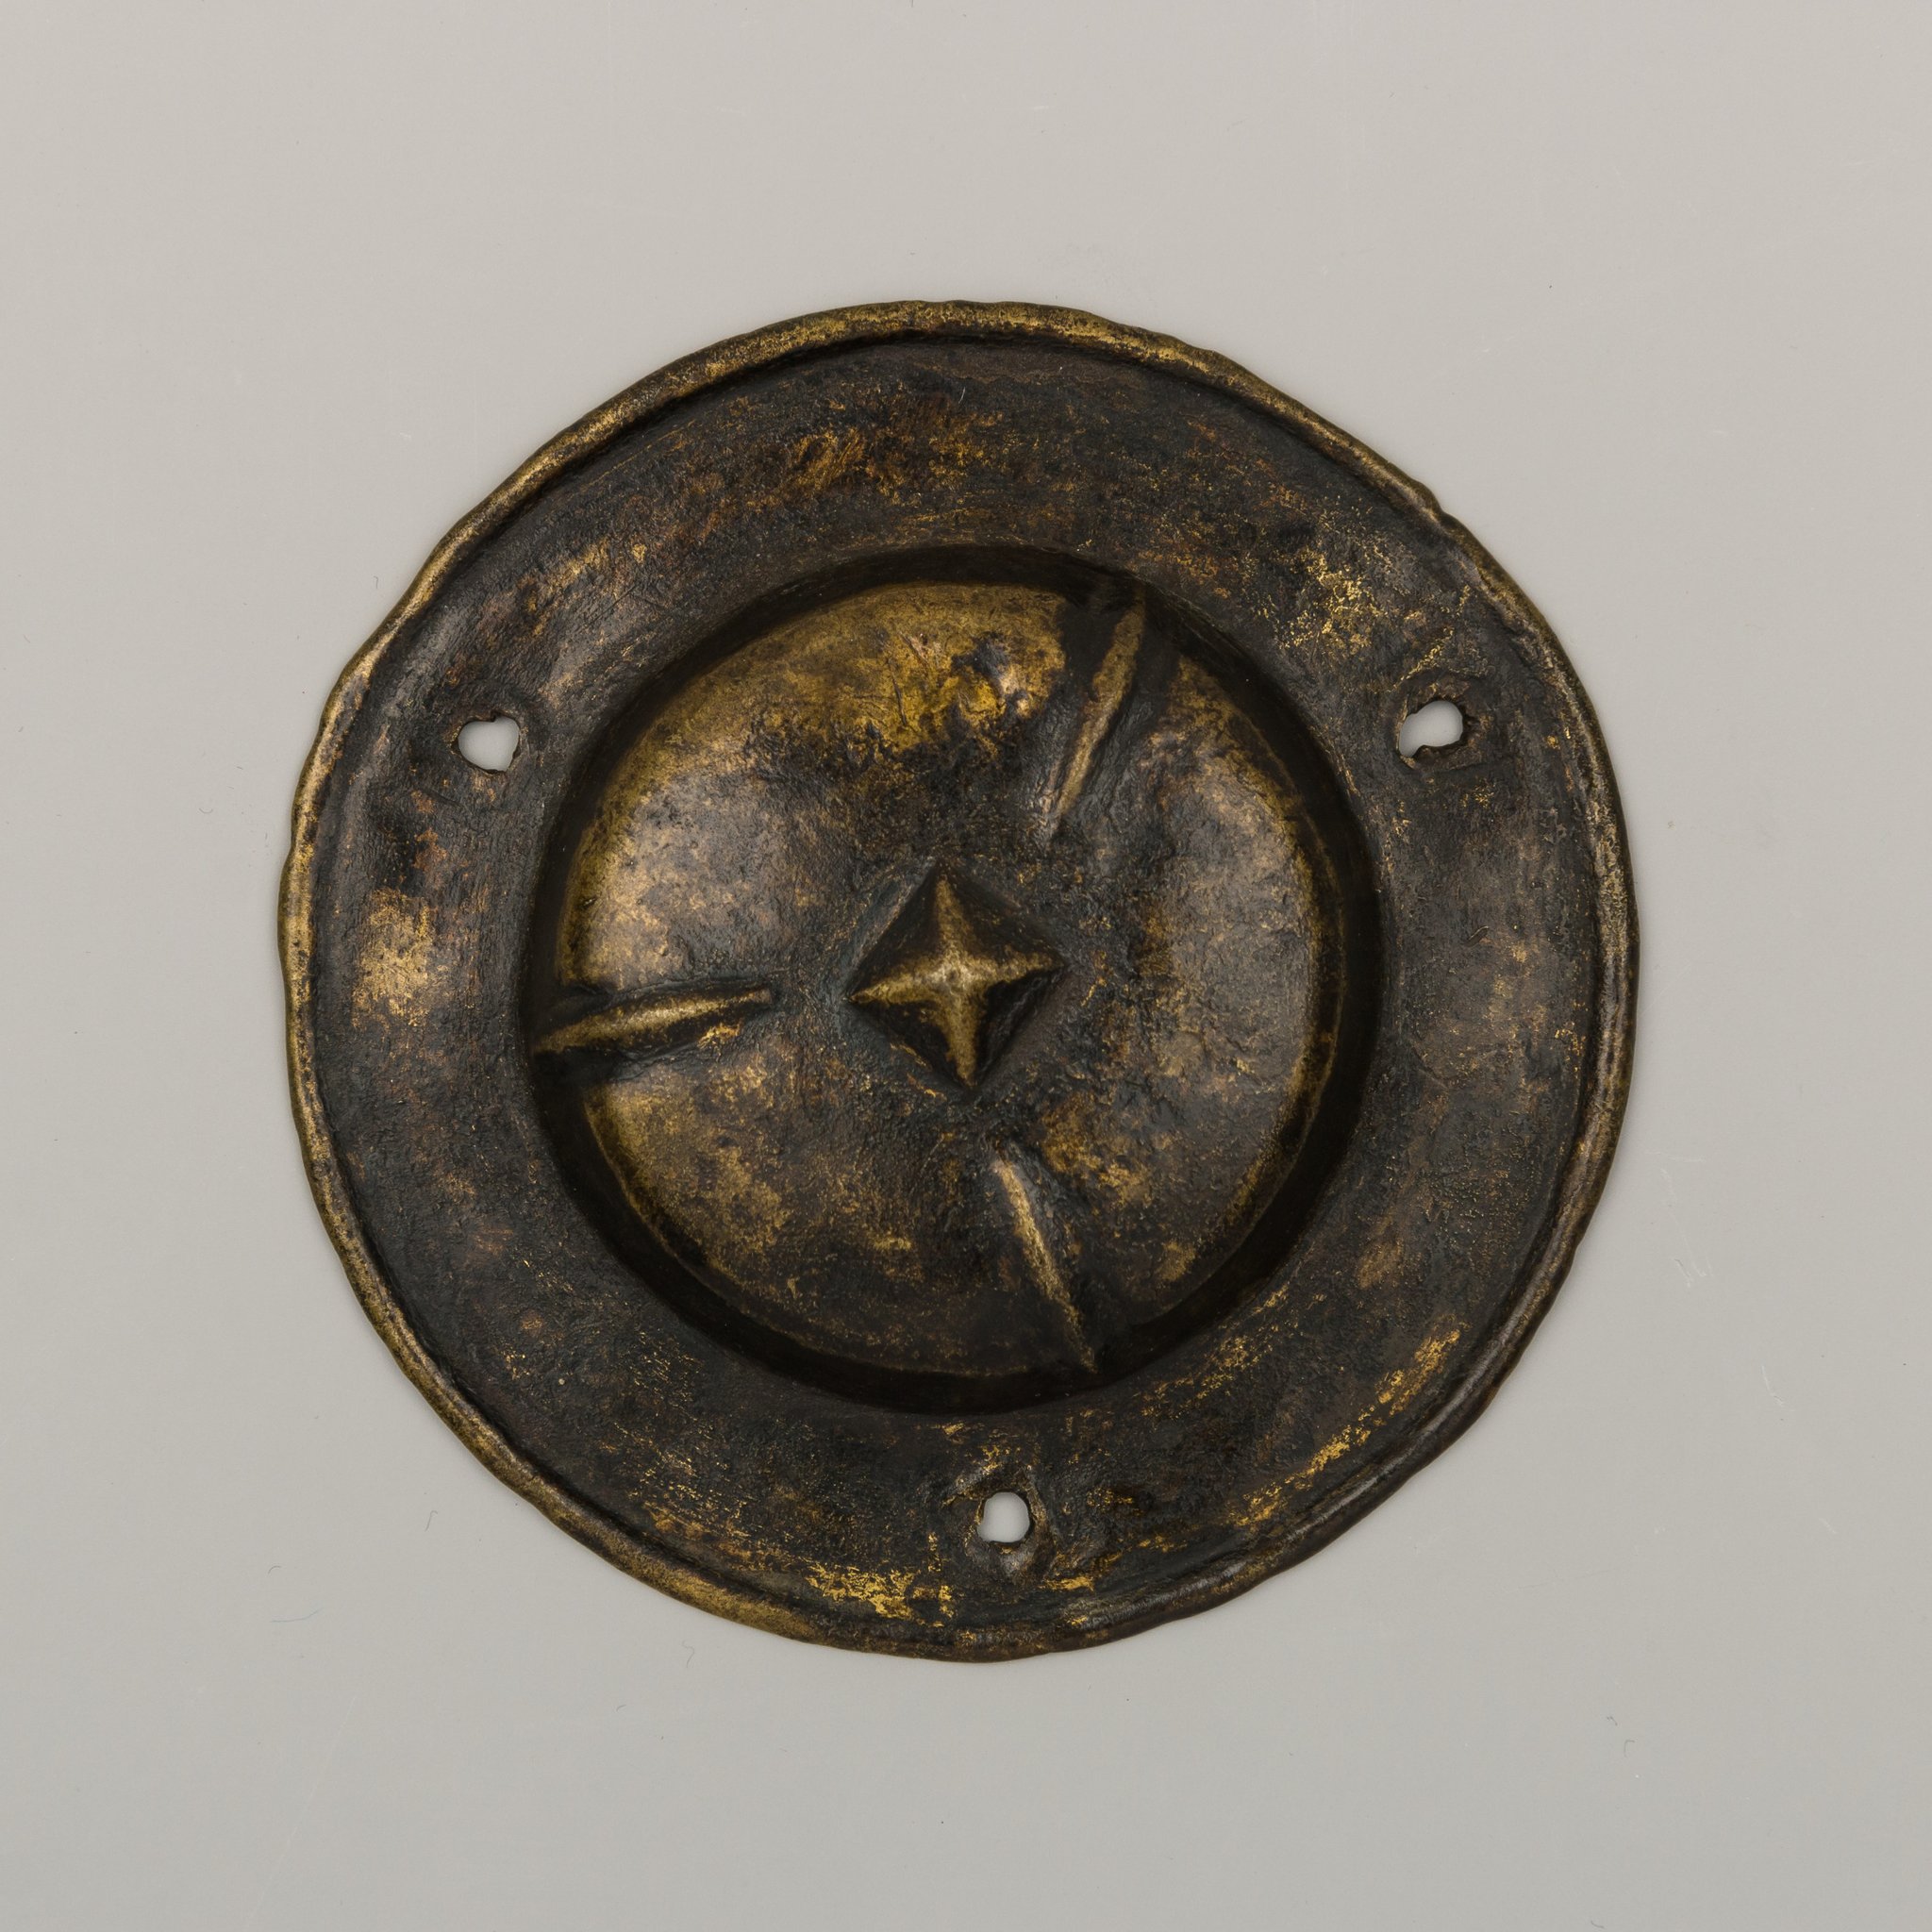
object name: bit bos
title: Bit Boss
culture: dutch or french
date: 1501-1600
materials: copper alloy, gold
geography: netherlands